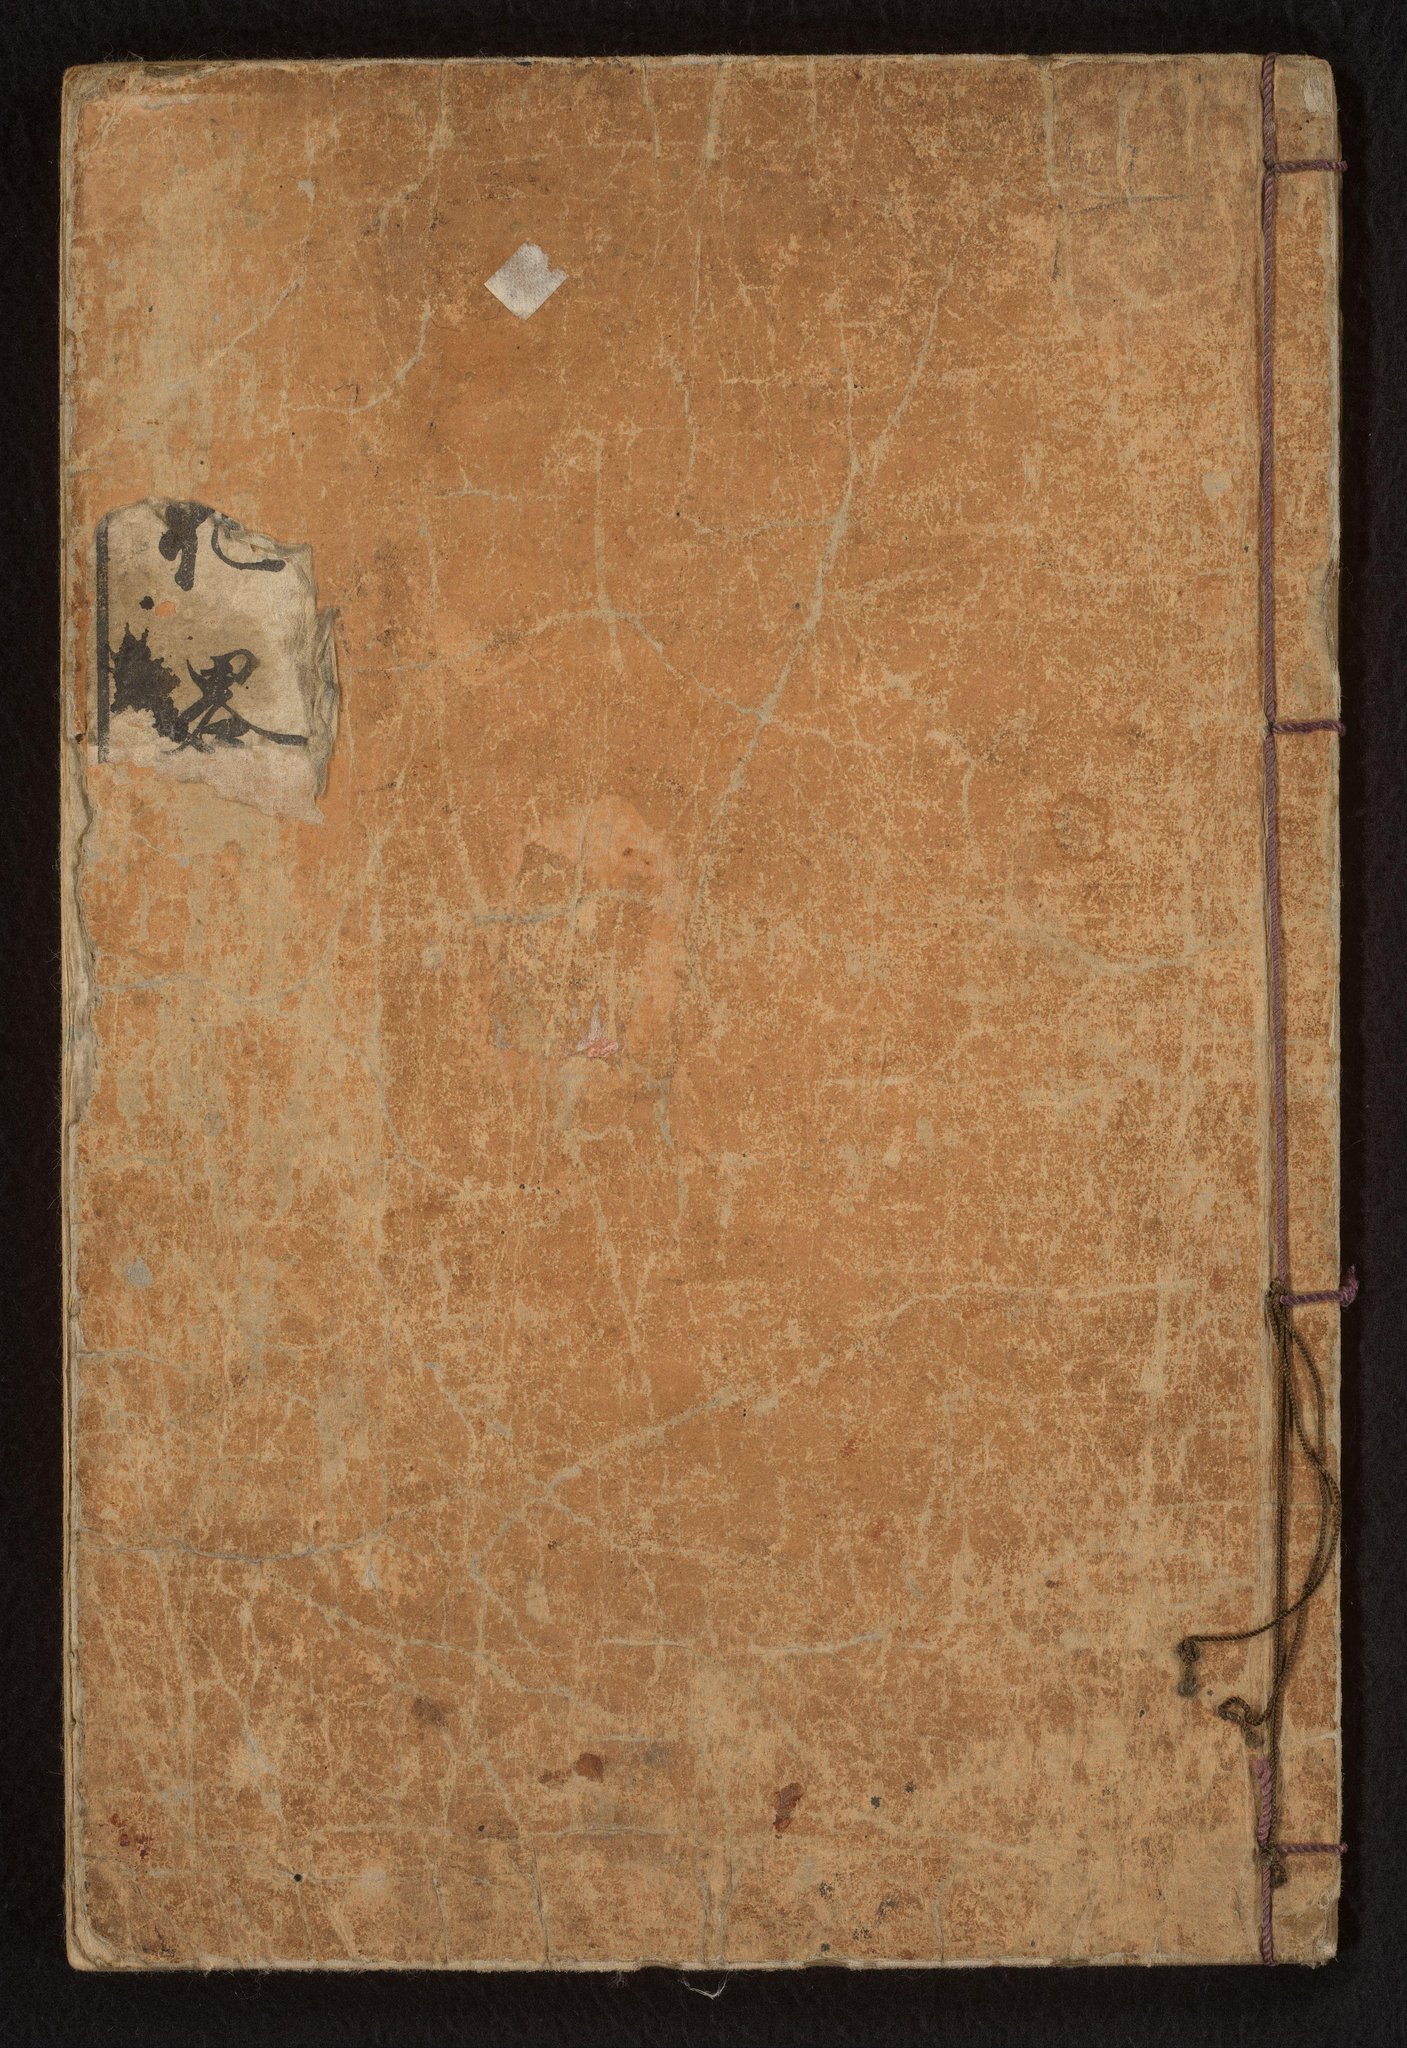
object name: book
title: Beknopte schetsen van bloeiende planten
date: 1813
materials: paper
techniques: woodcut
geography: edo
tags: flowers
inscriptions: collector's mark: Lugt 2228